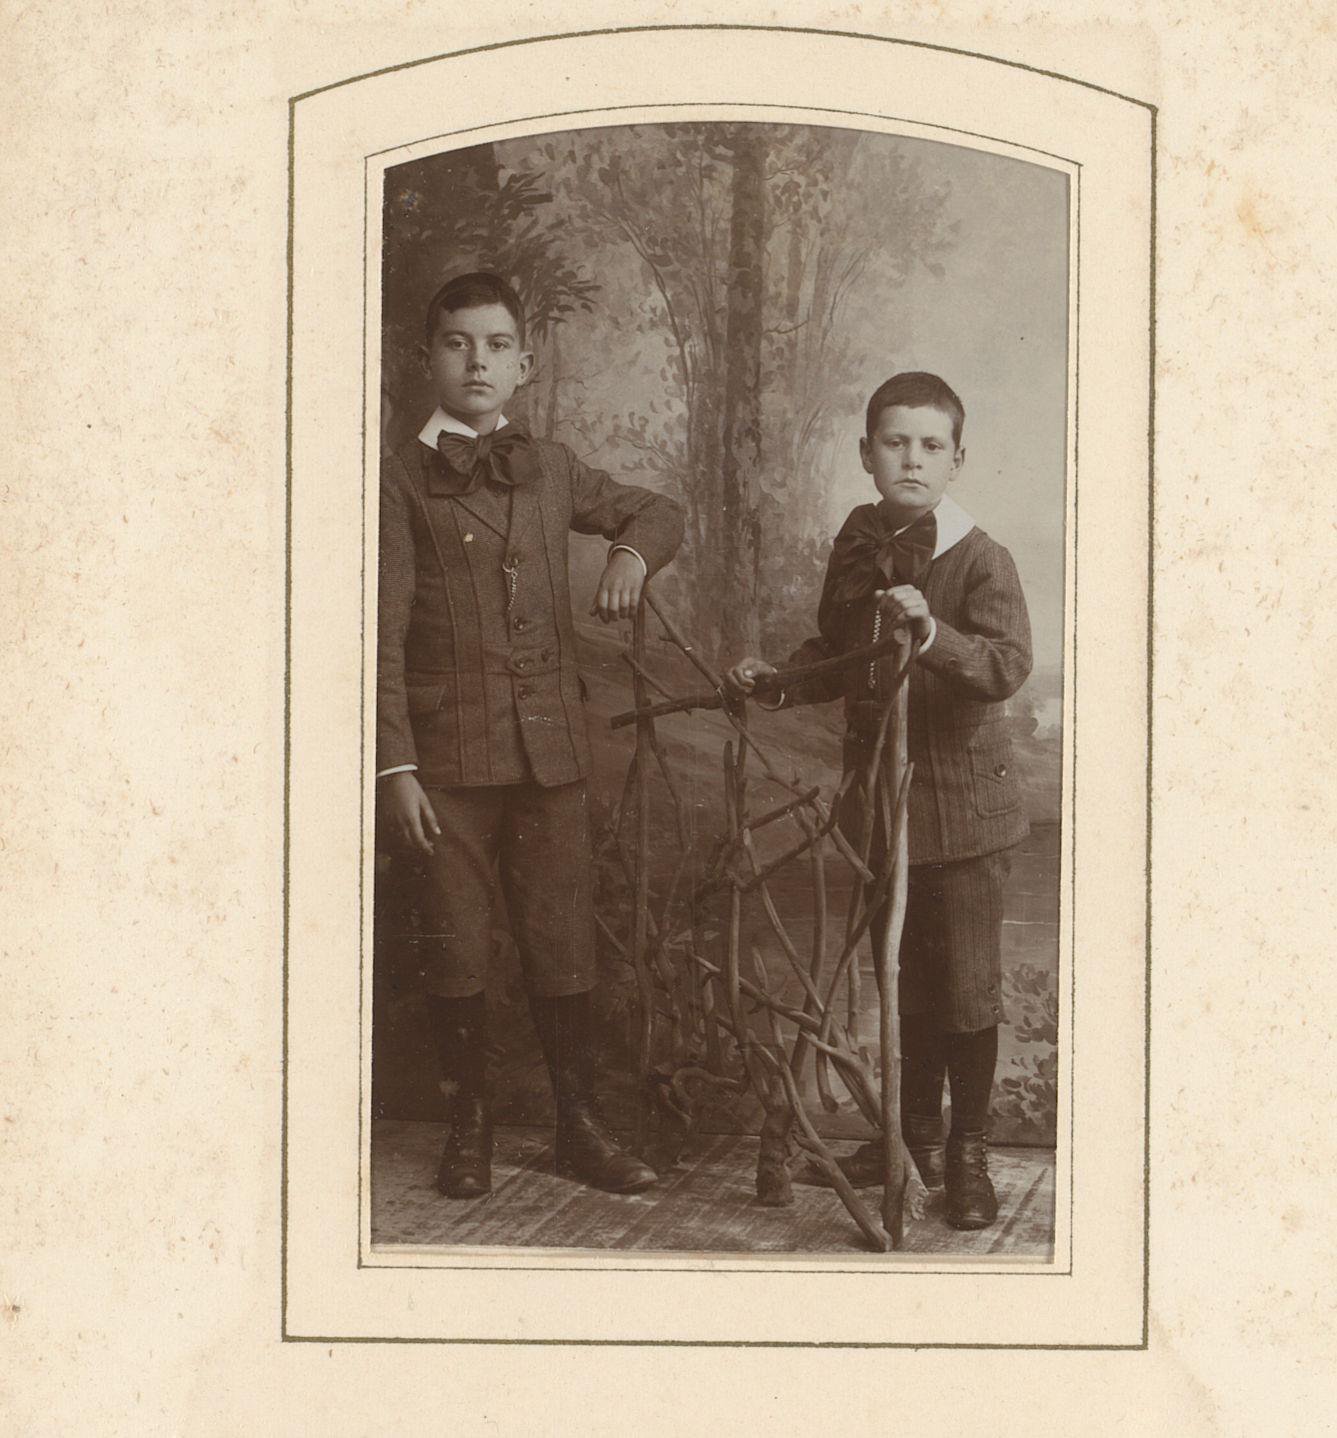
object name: album leaf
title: Portret van twee jongens bij een hek van takken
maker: jan van roon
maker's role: fotograaf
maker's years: 1879-1948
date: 1903-1948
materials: cardboard, photographic support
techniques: collodion silver print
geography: haarlem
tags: boy (child between toddler and youth) (+ two persons), fence, wall, paling, historical persons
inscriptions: inscription: ‘J. van Roon/ GENERAAL CRONJÉ STRAAT 45-47/ HAARLEM.’